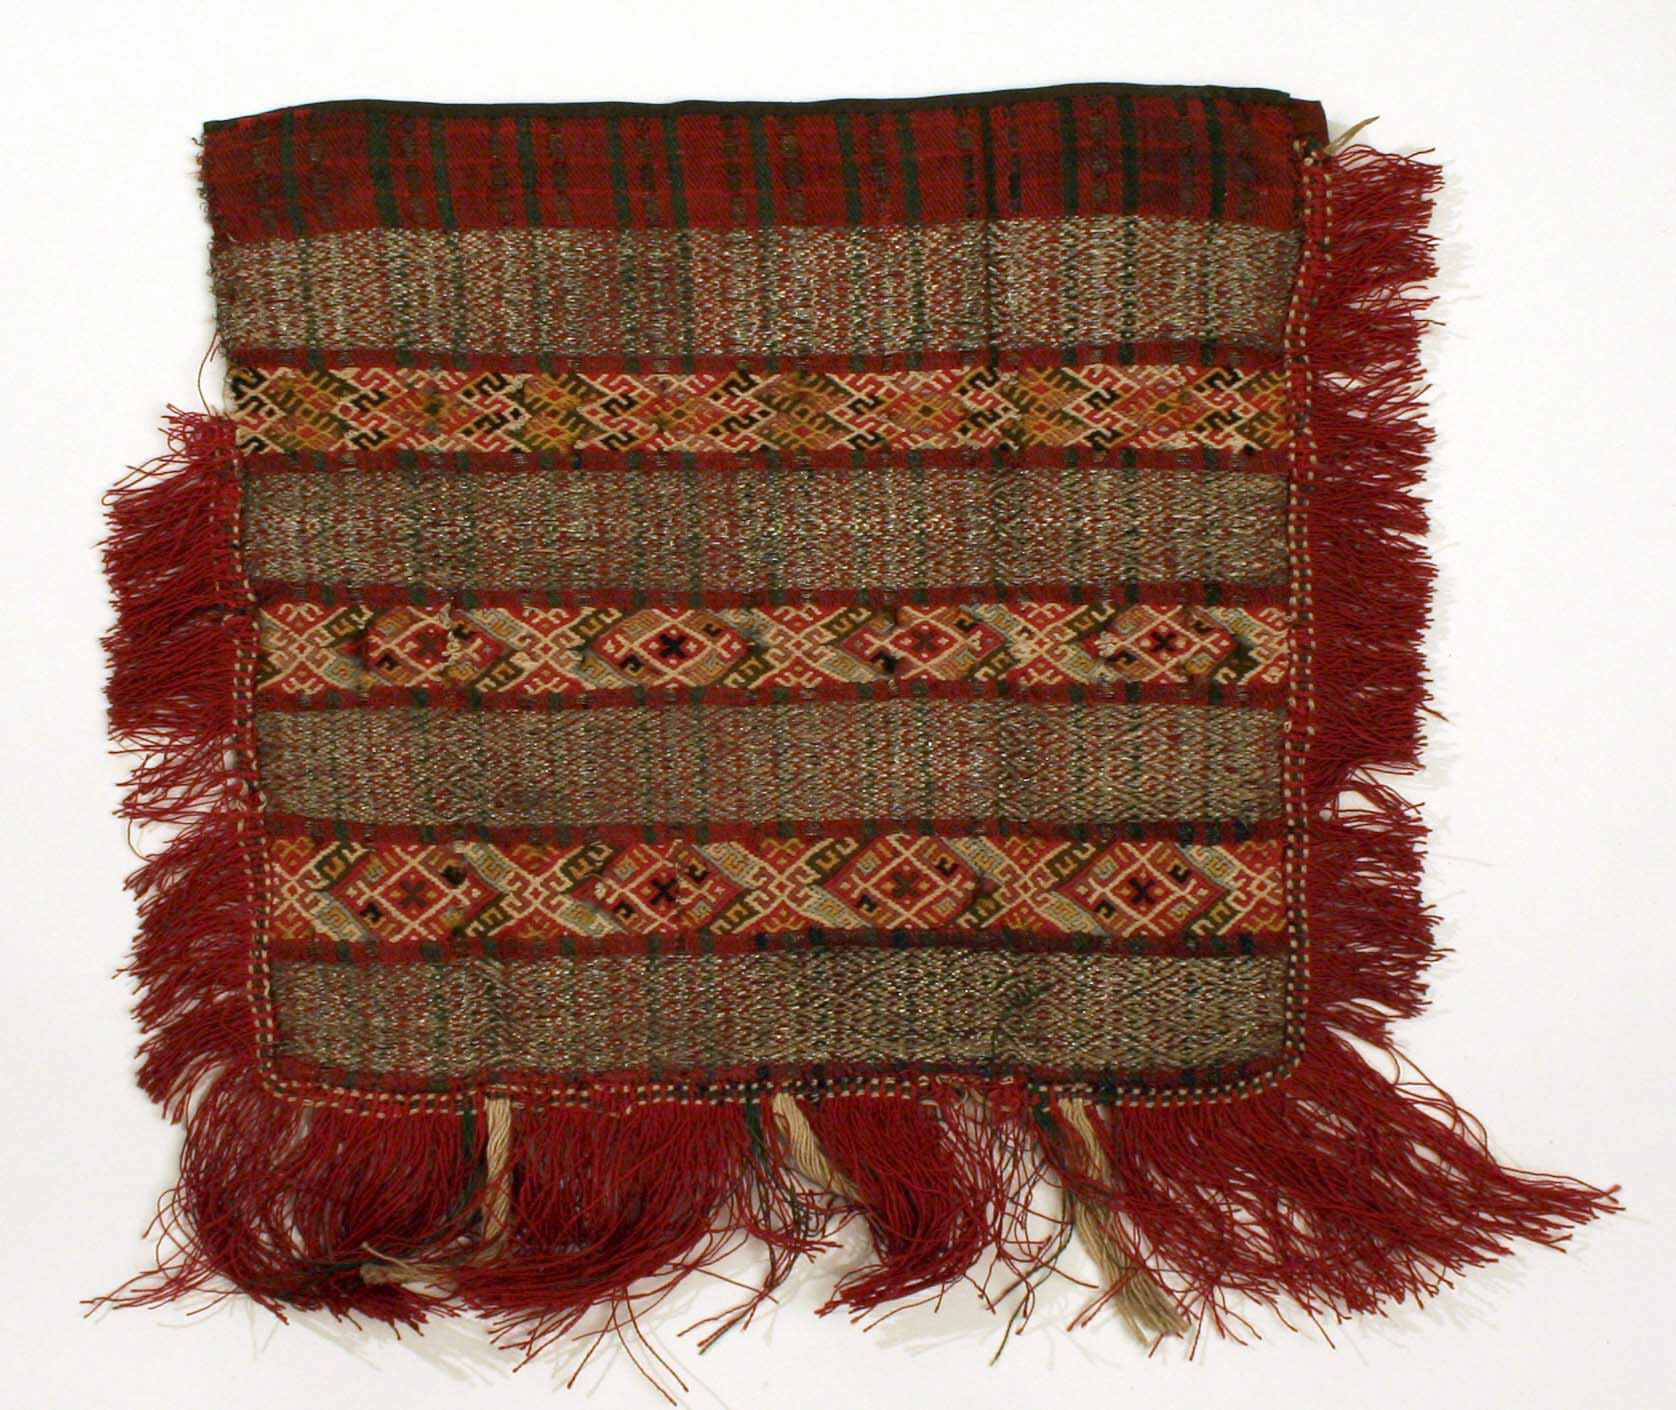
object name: apron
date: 1801-1900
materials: wool